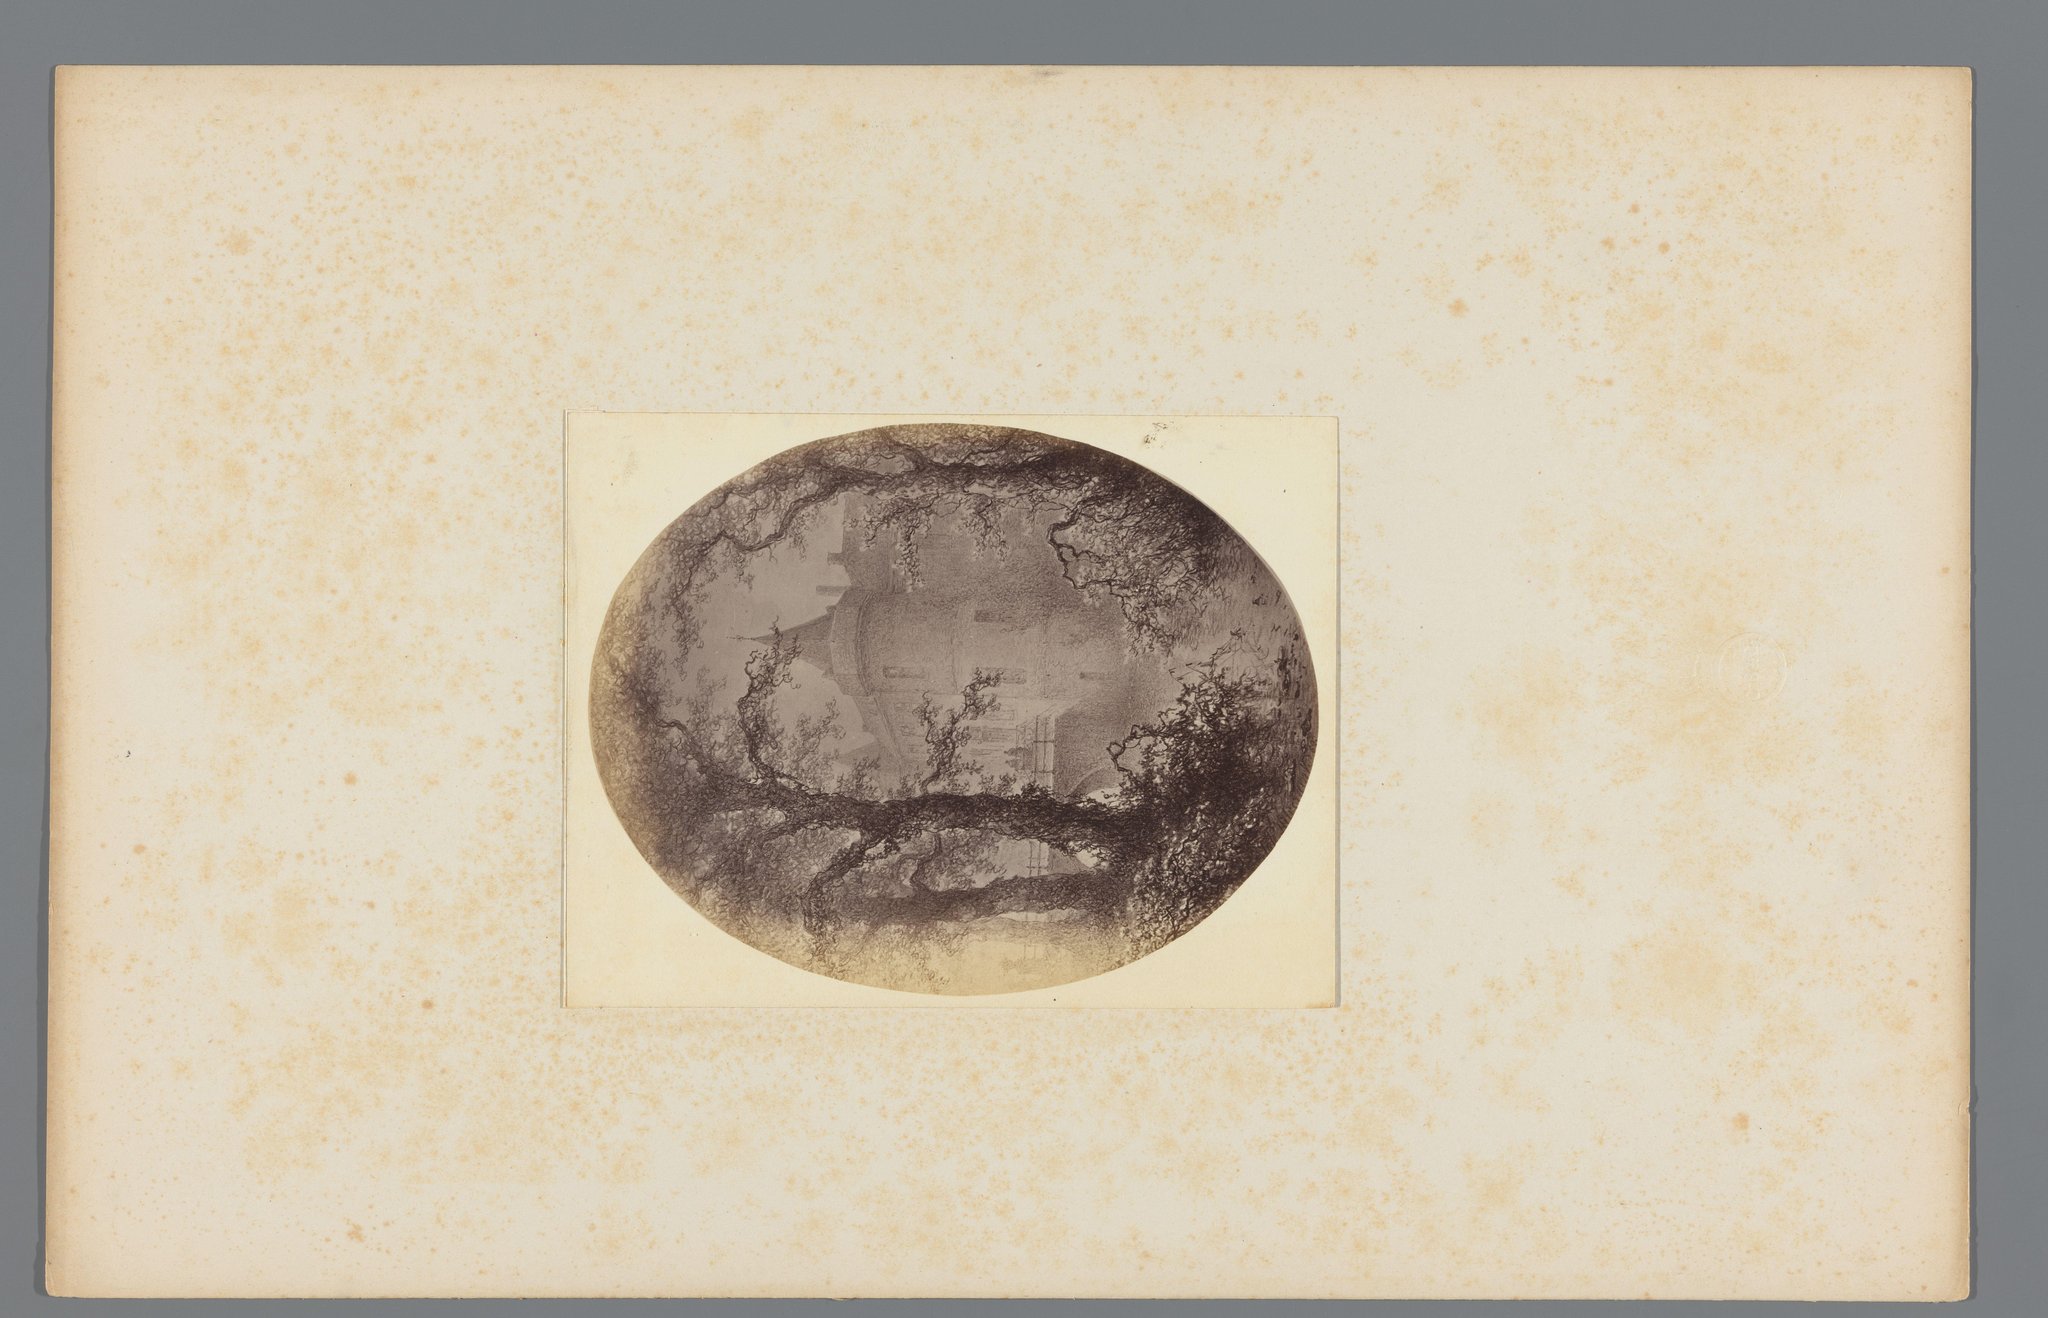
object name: reproduction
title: Fotoreproductie van het schilderij 'Het kasteel' door Johannes Hilverdink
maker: johannes hilverdink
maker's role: draughtsman, painter, print maker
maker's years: 1813-1902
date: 1866-1871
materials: paper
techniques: albumen print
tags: castle